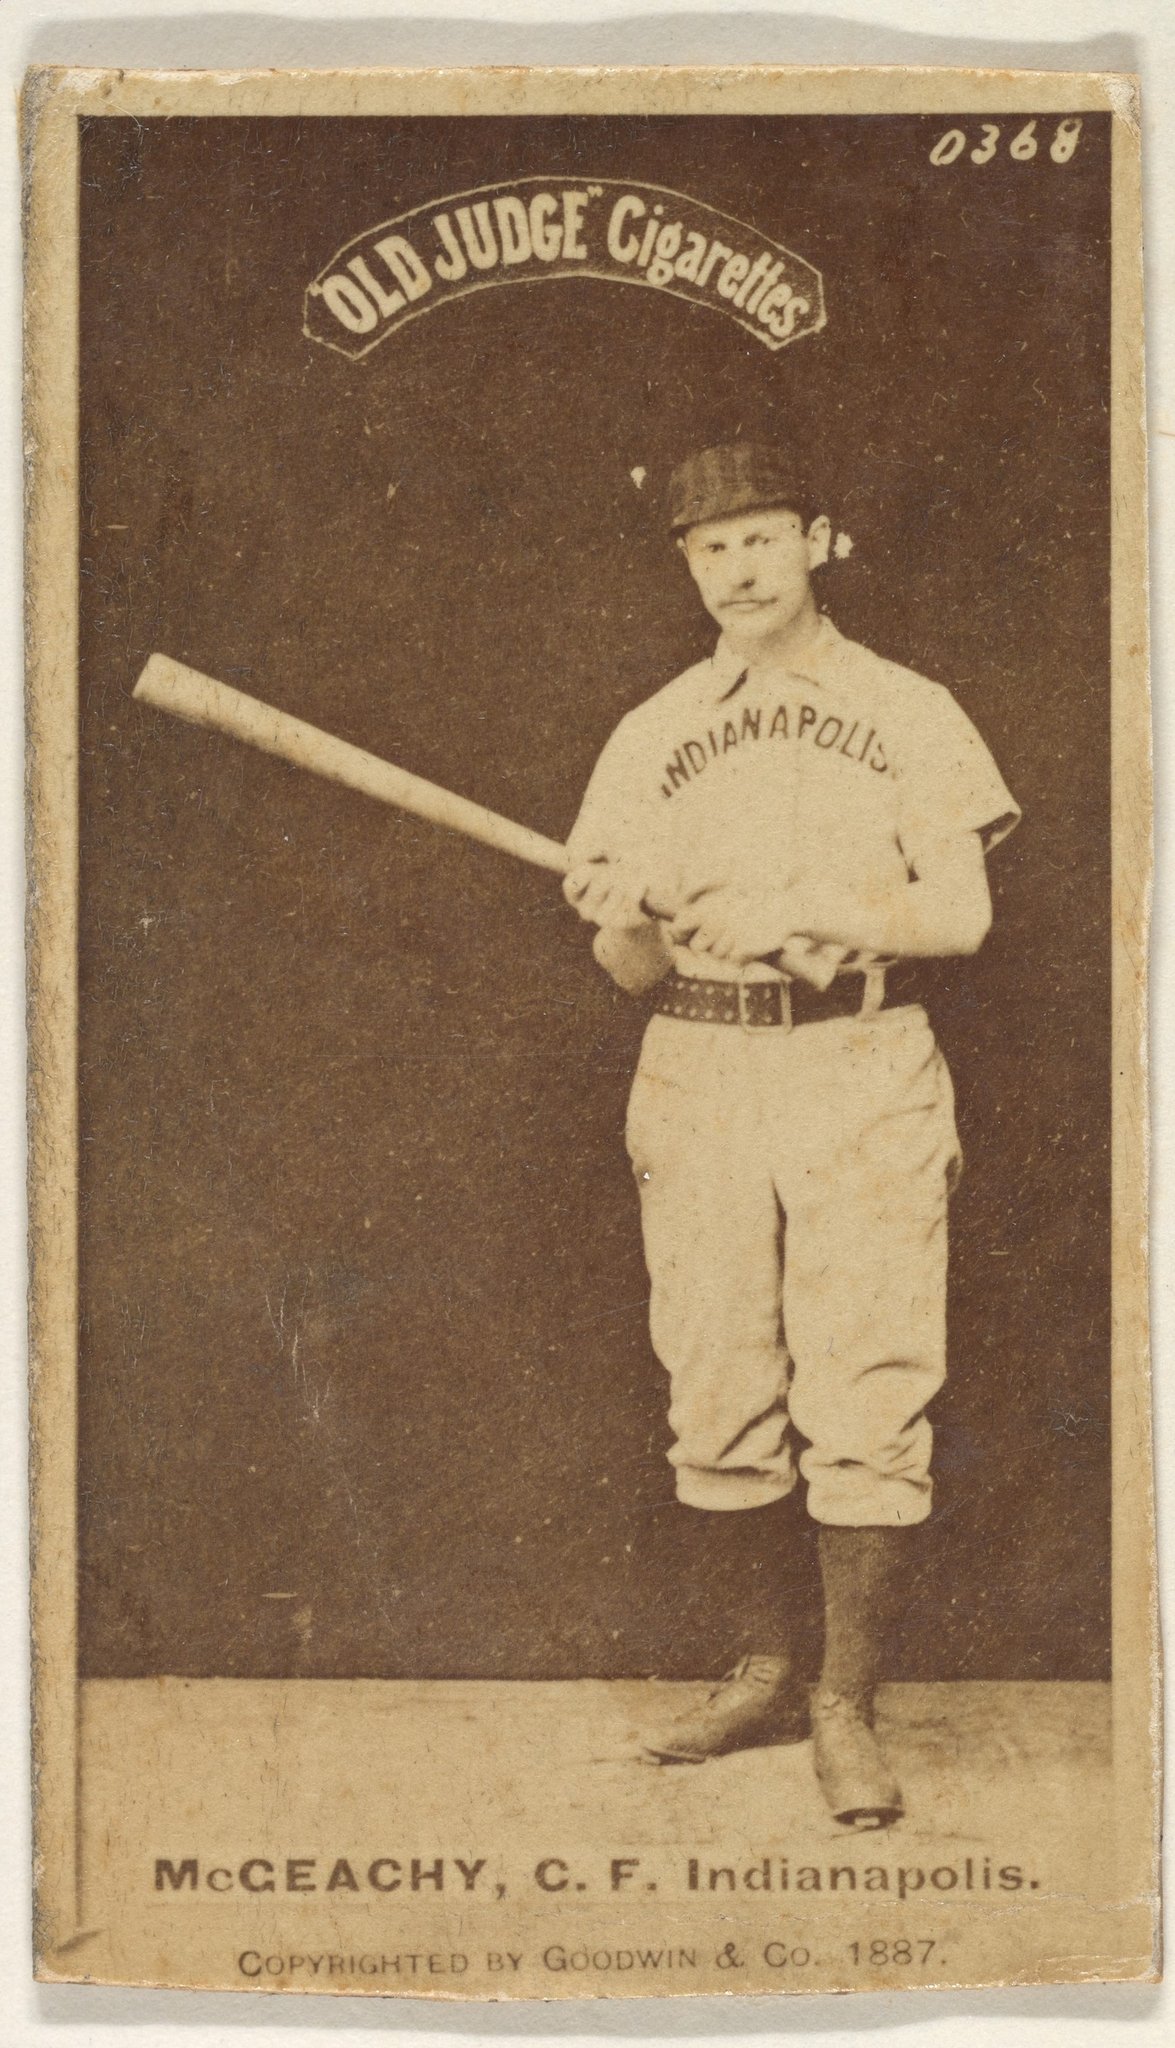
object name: baseball card, photograph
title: Jack McGeachey, Center Field, Indianapolis, from the Old Judge series (N172) for Old Judge Cigarettes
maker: goodwin & company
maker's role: publisher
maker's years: 1850-1950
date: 1887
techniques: albumen silver print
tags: men,portraits,baseball,athletes